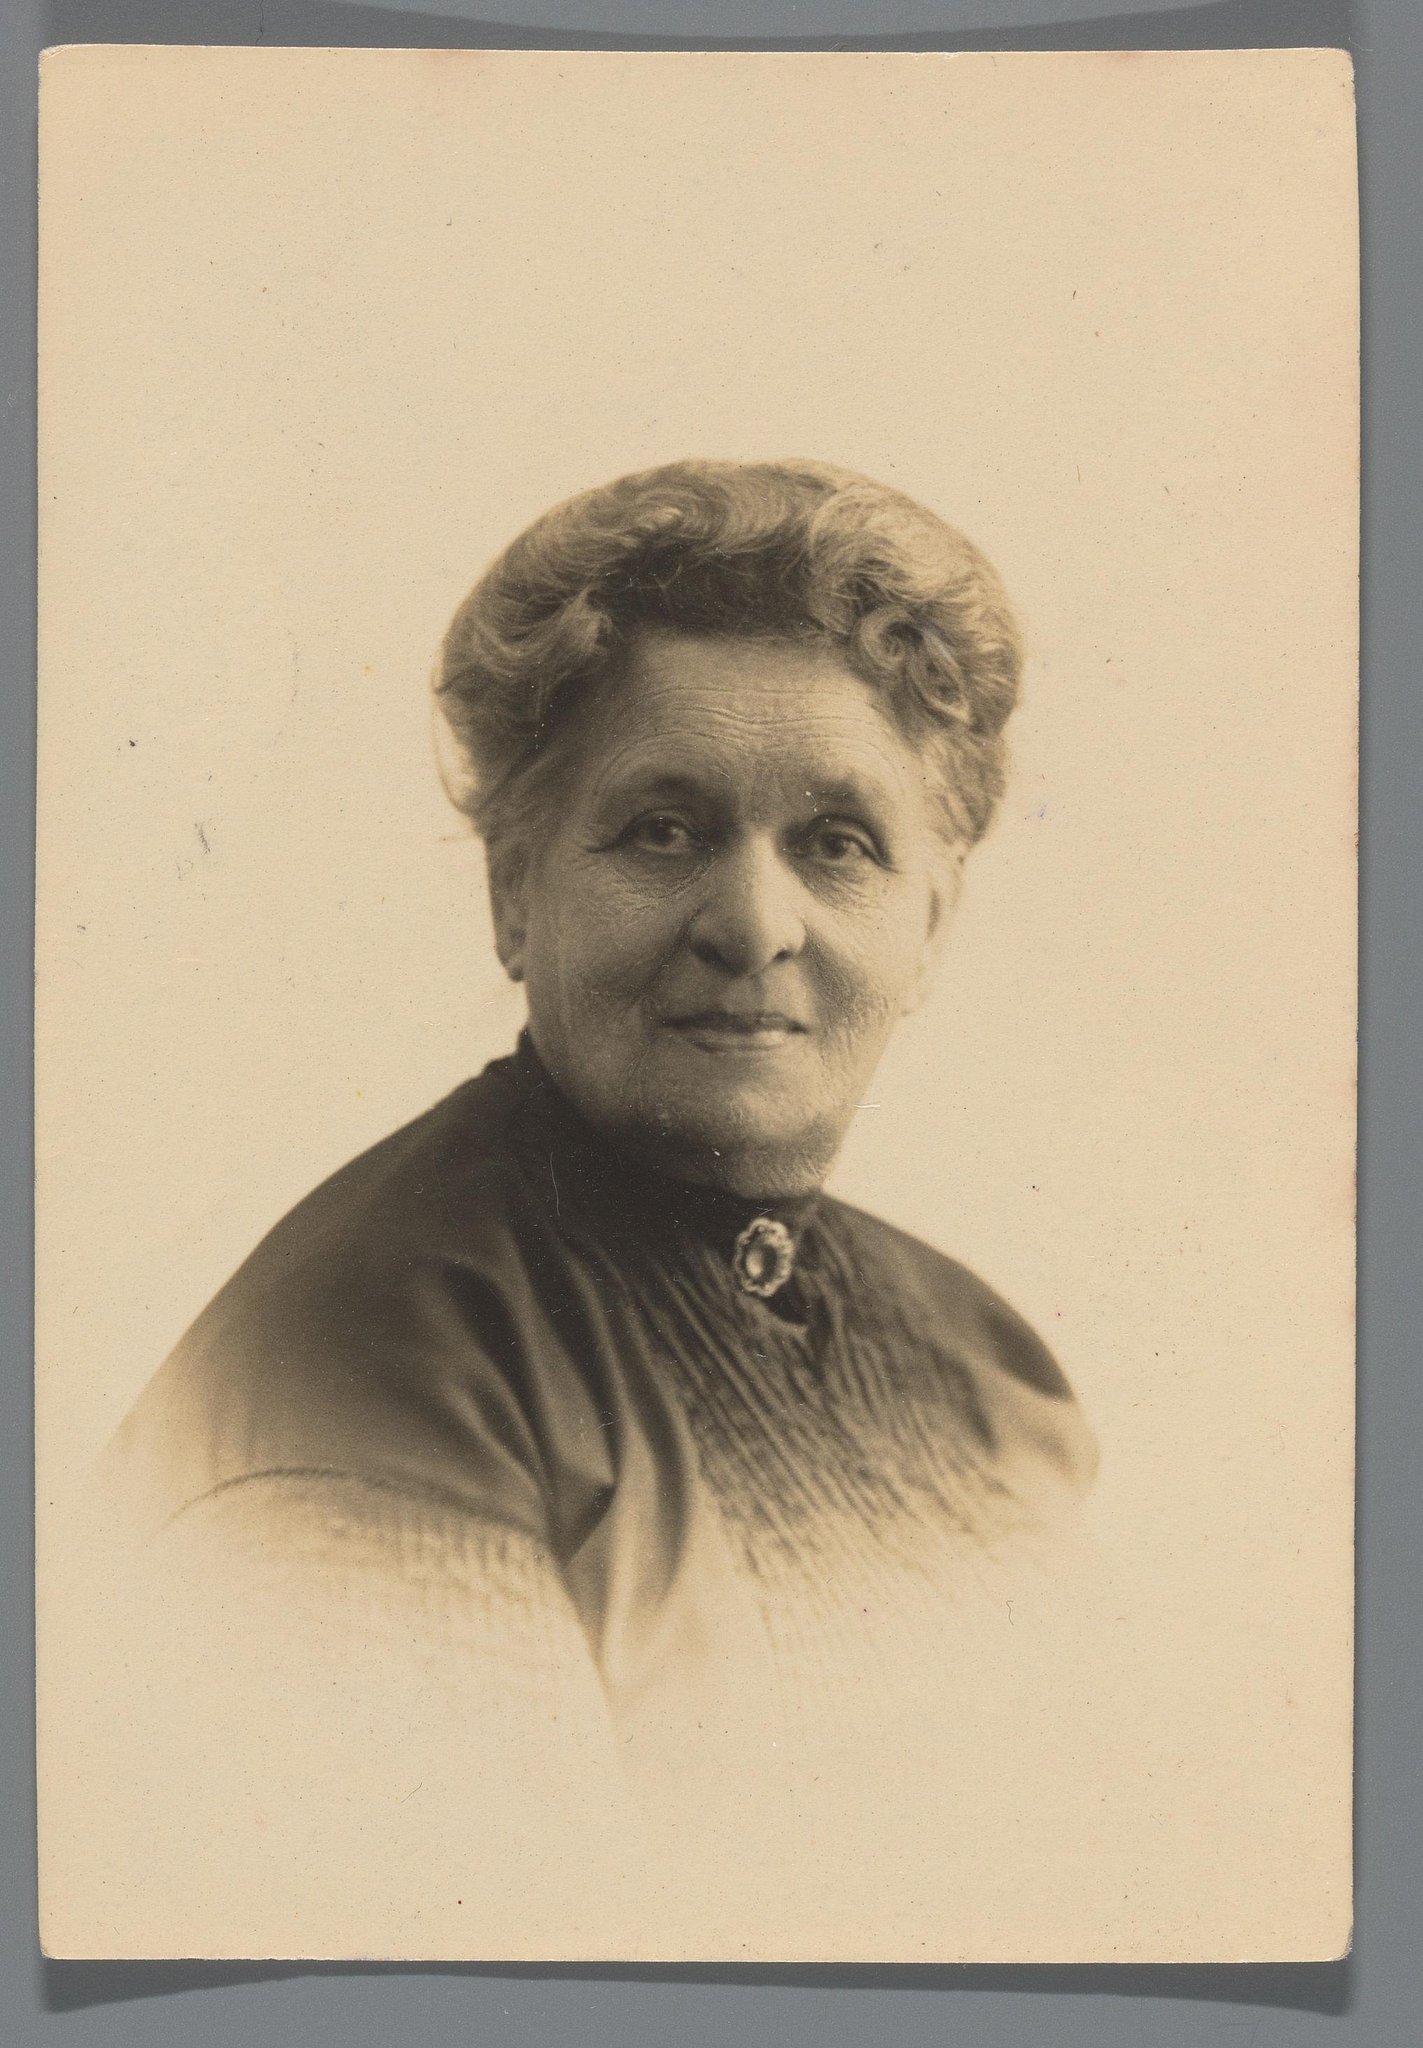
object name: photograph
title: Portret van Francina Schas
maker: Anonymous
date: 1890-1930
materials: photographic support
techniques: albumen print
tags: francina schas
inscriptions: inscription: ‘Grootmoeder / F.W.S. vandenBerg / Schas / 1853 _ 1932+’